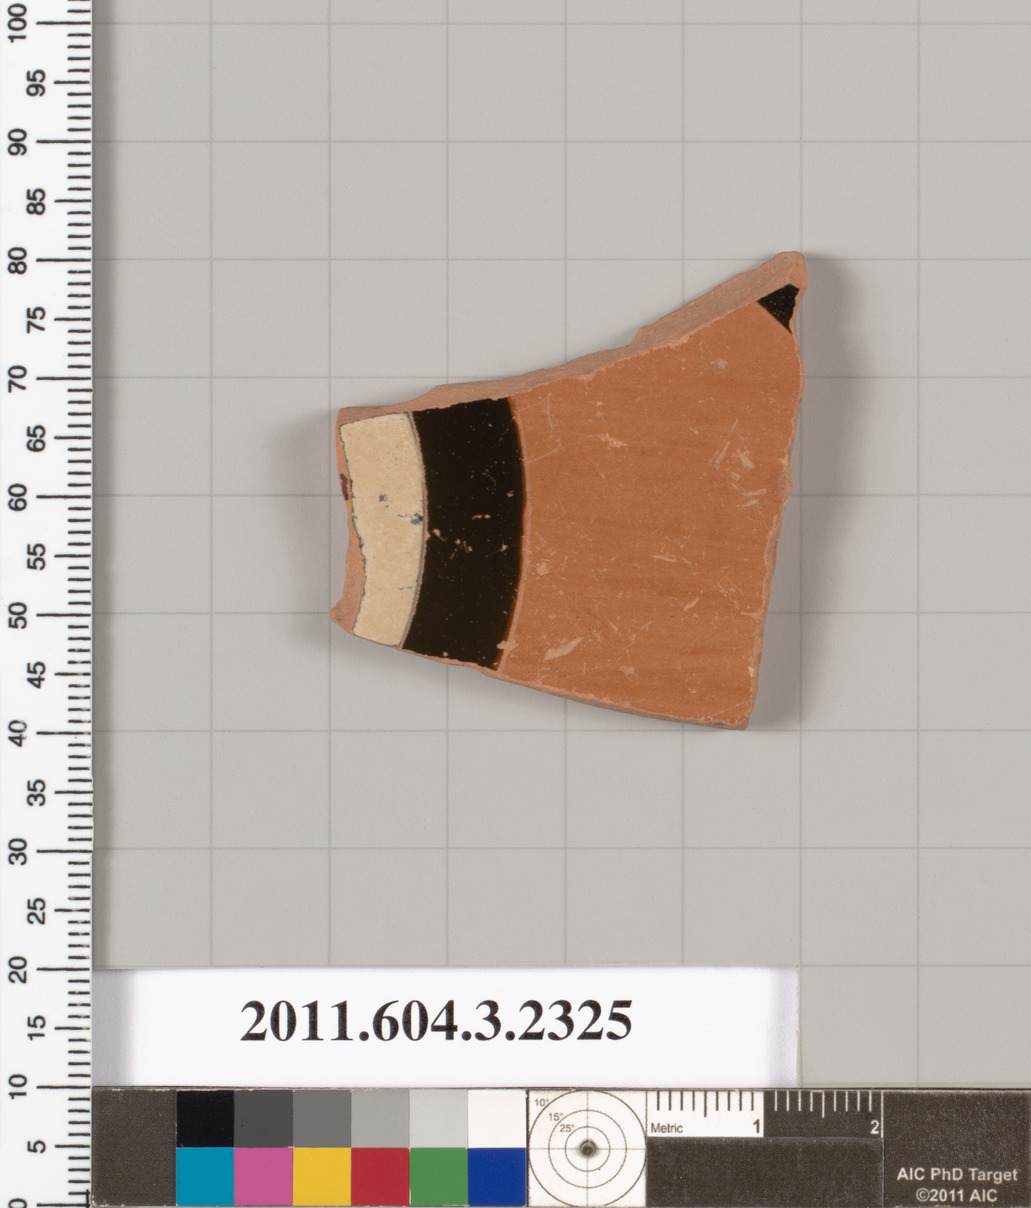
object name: kylix fragment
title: Terracotta fragment of a kylix: eye-cup (drinking cup)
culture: greek, attic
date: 540-520 BCE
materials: terracotta